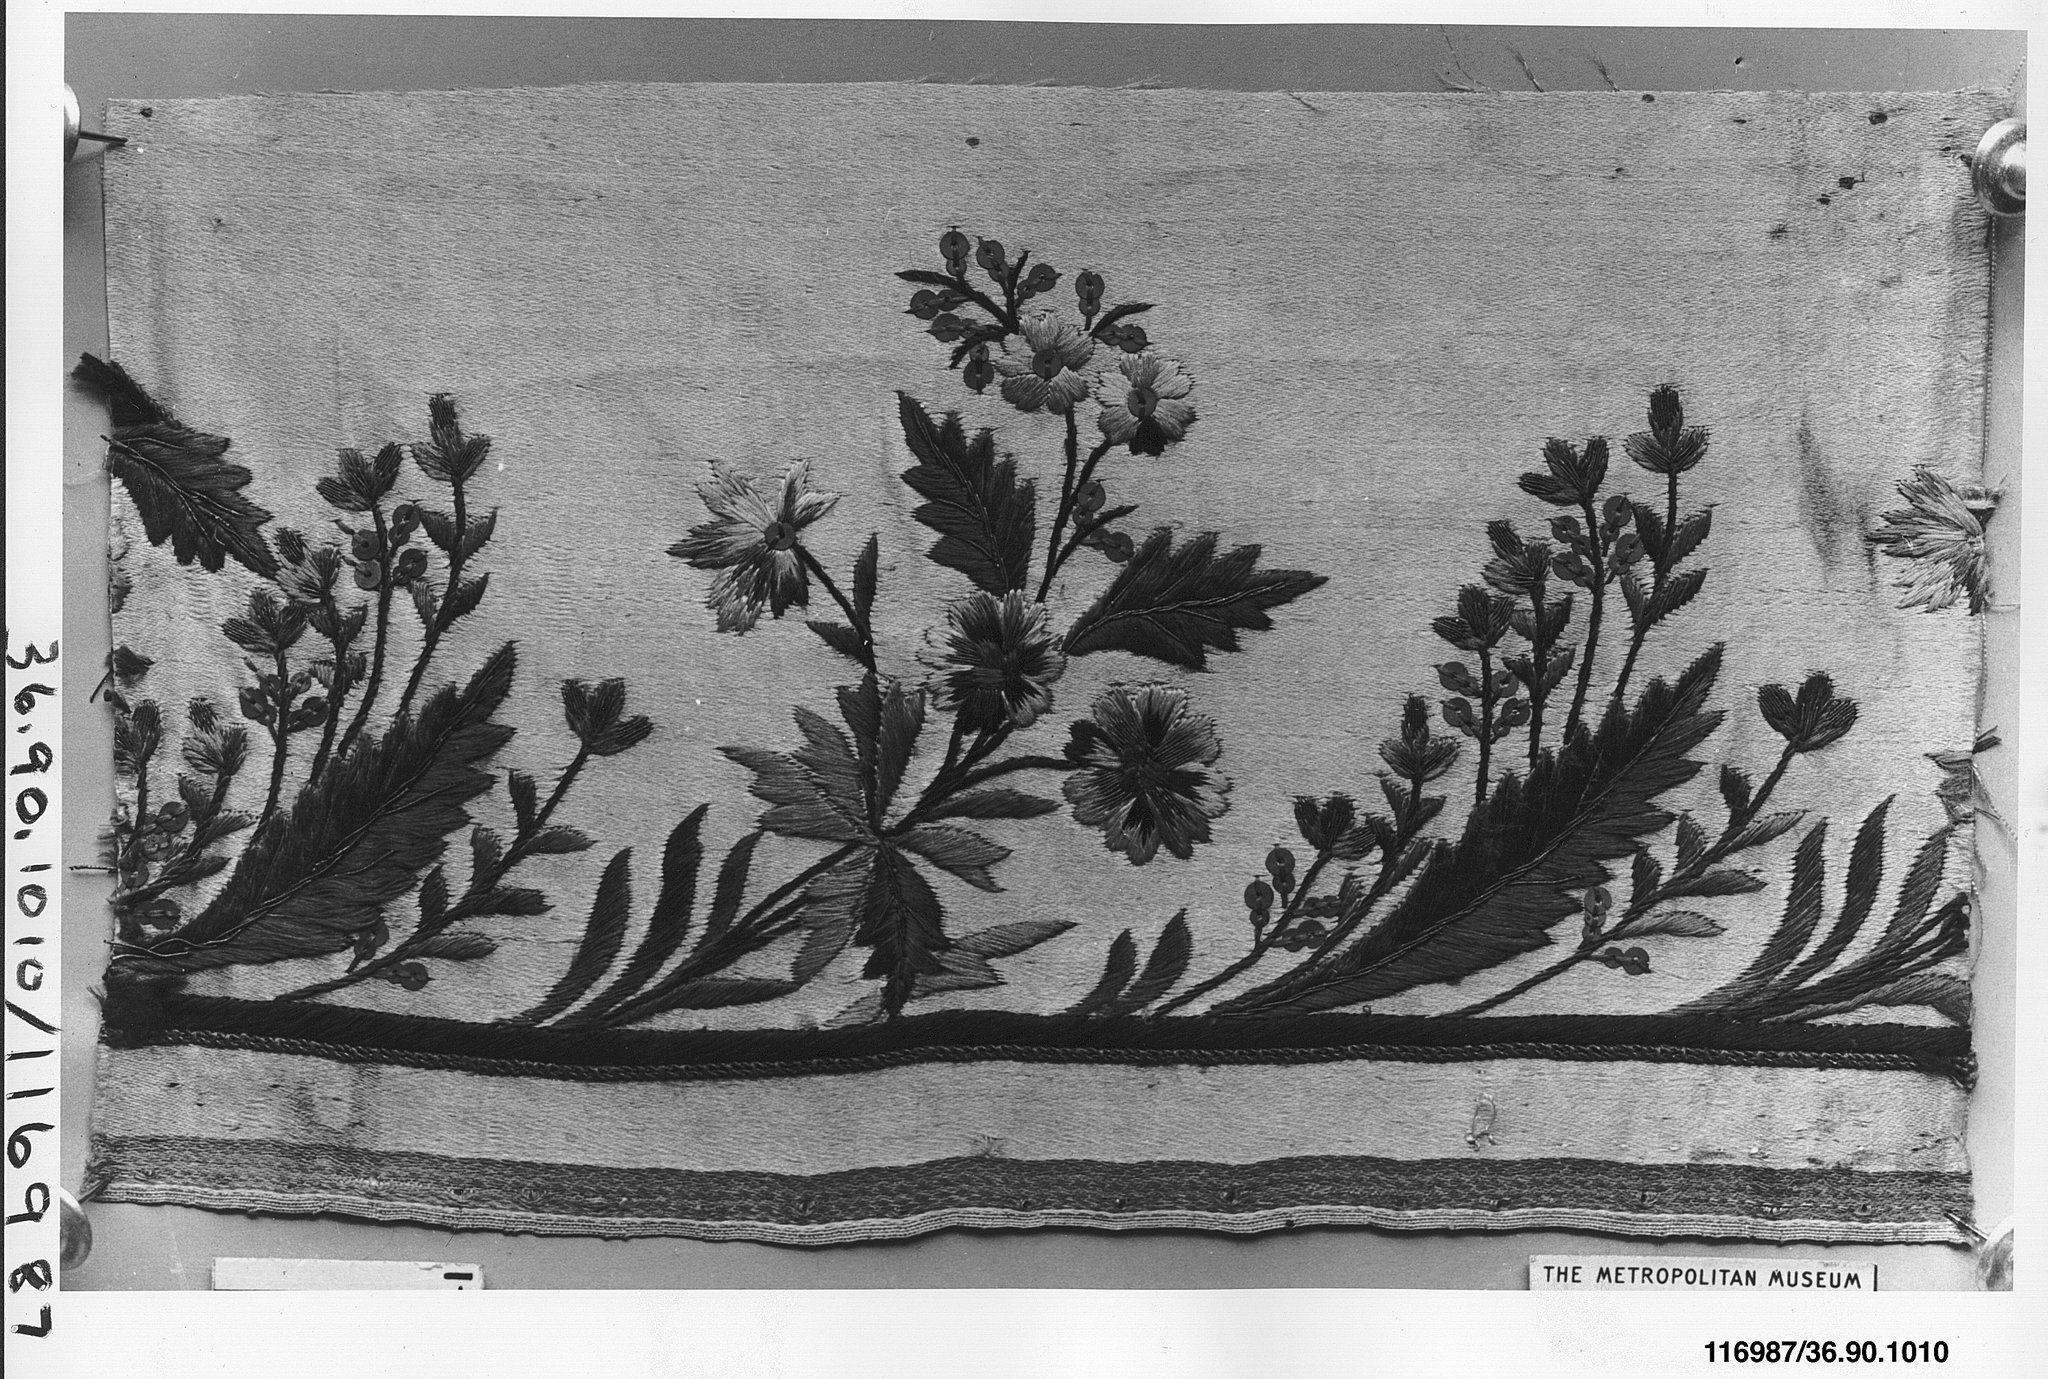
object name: piece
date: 1801-1833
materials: silk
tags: flowers,leaves